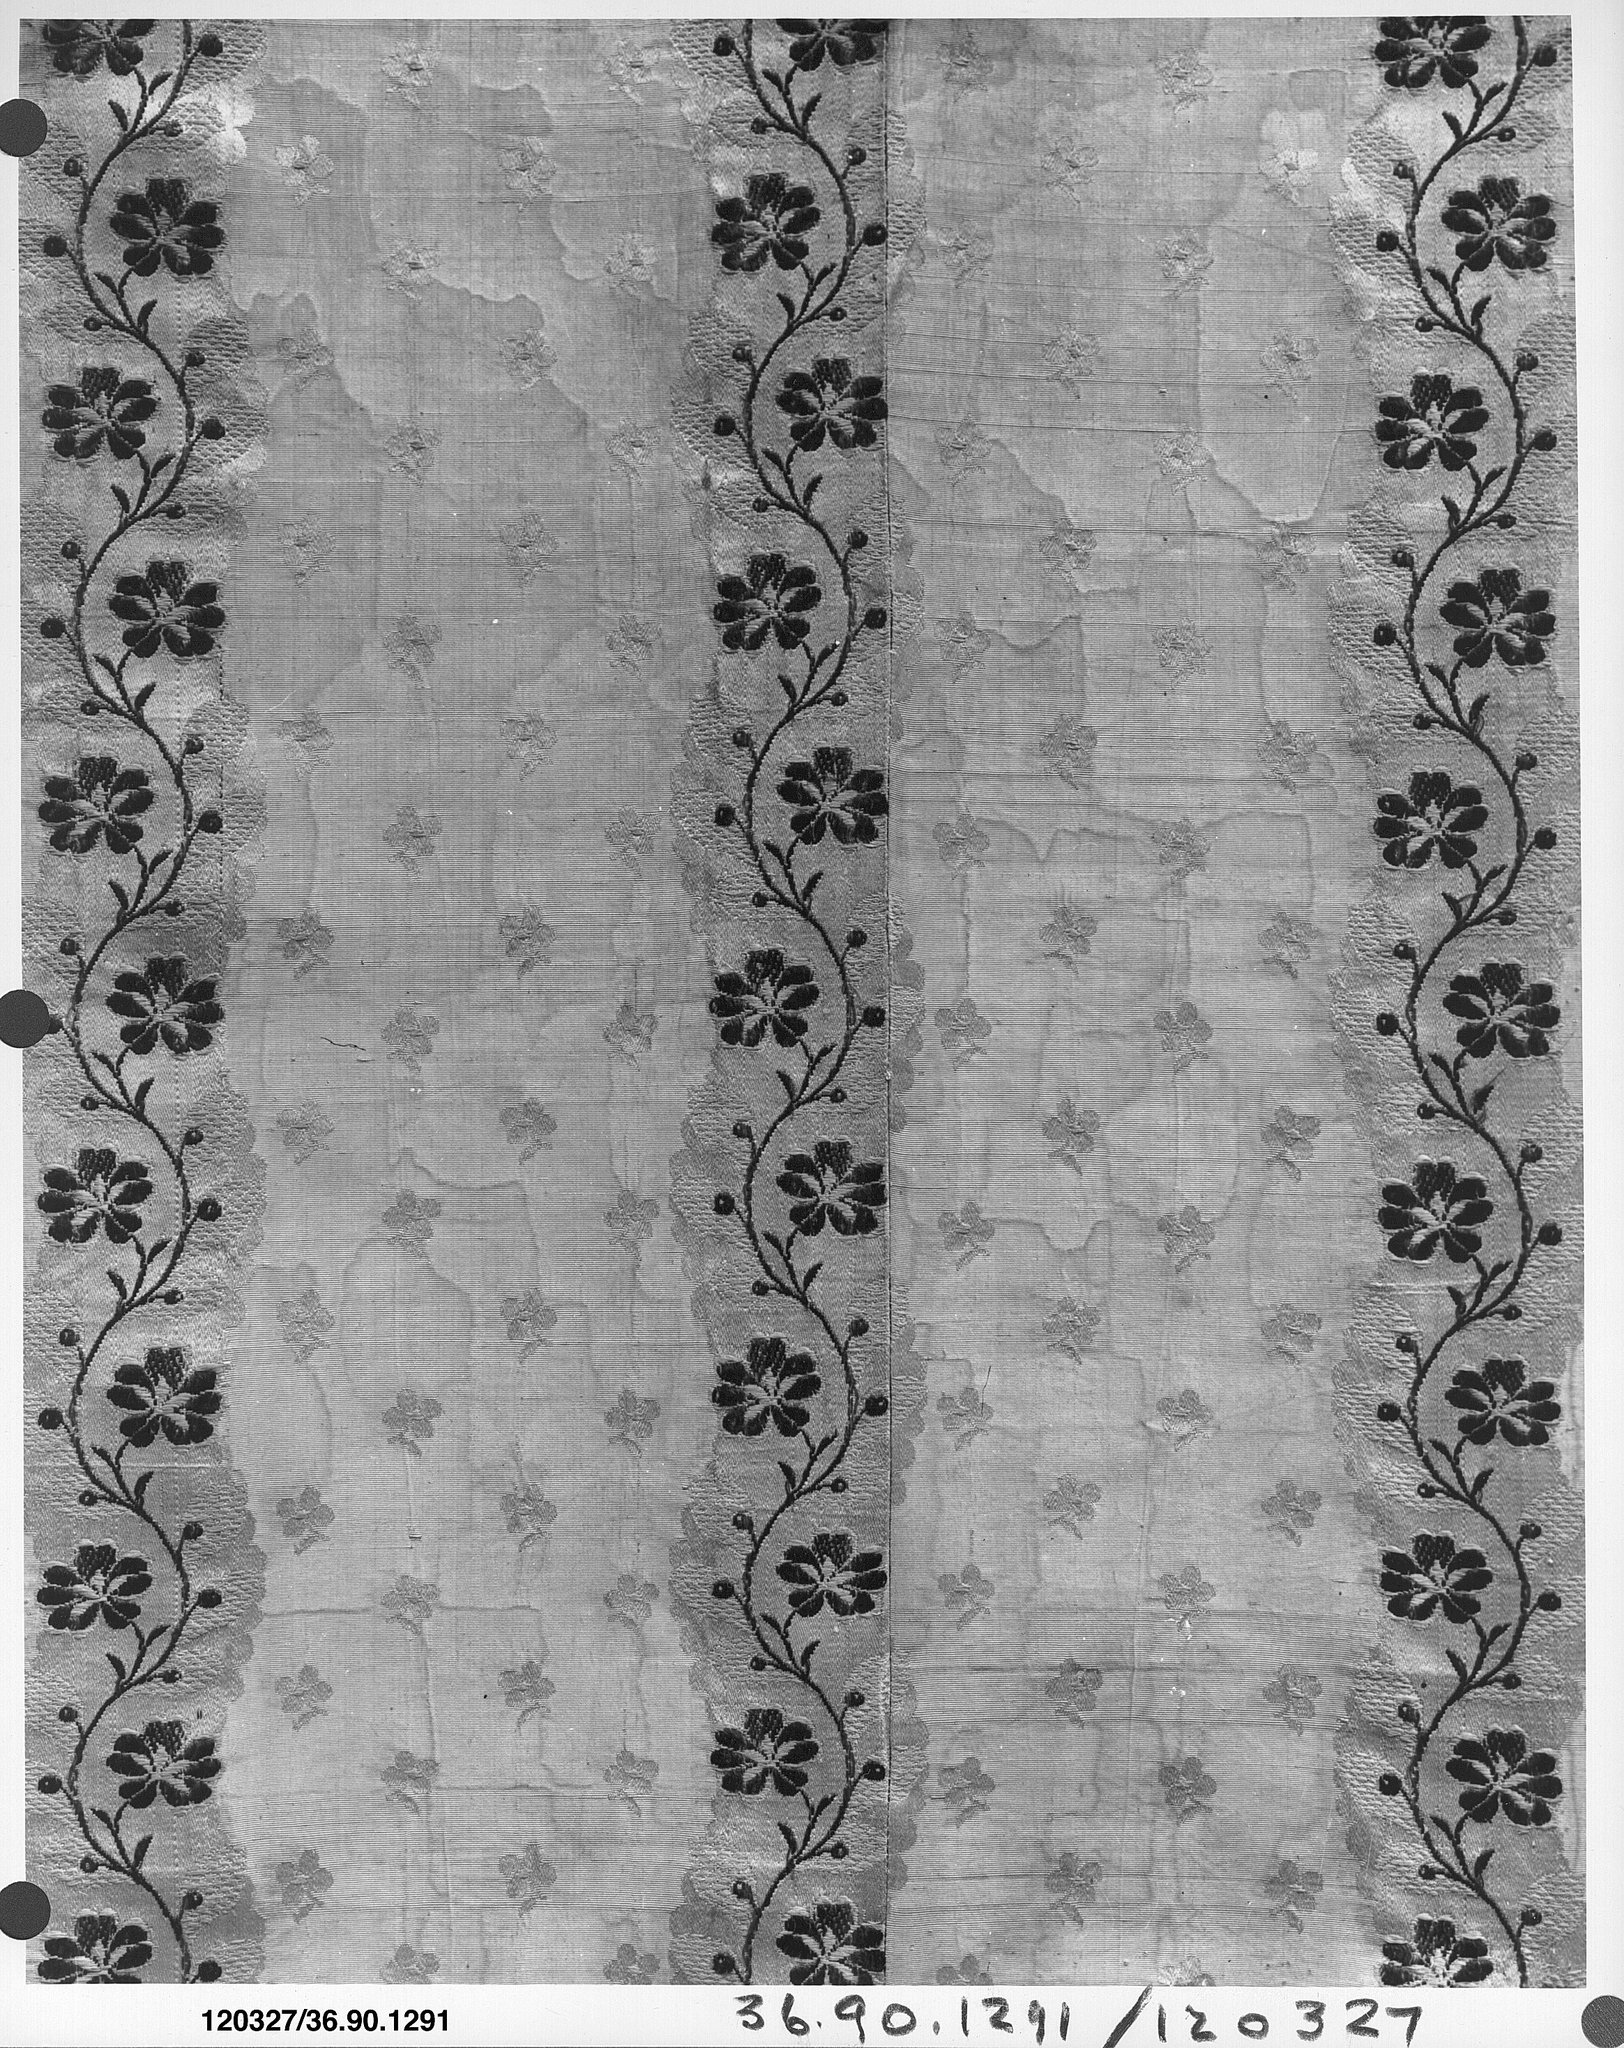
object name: piece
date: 1770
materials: silk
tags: flowers